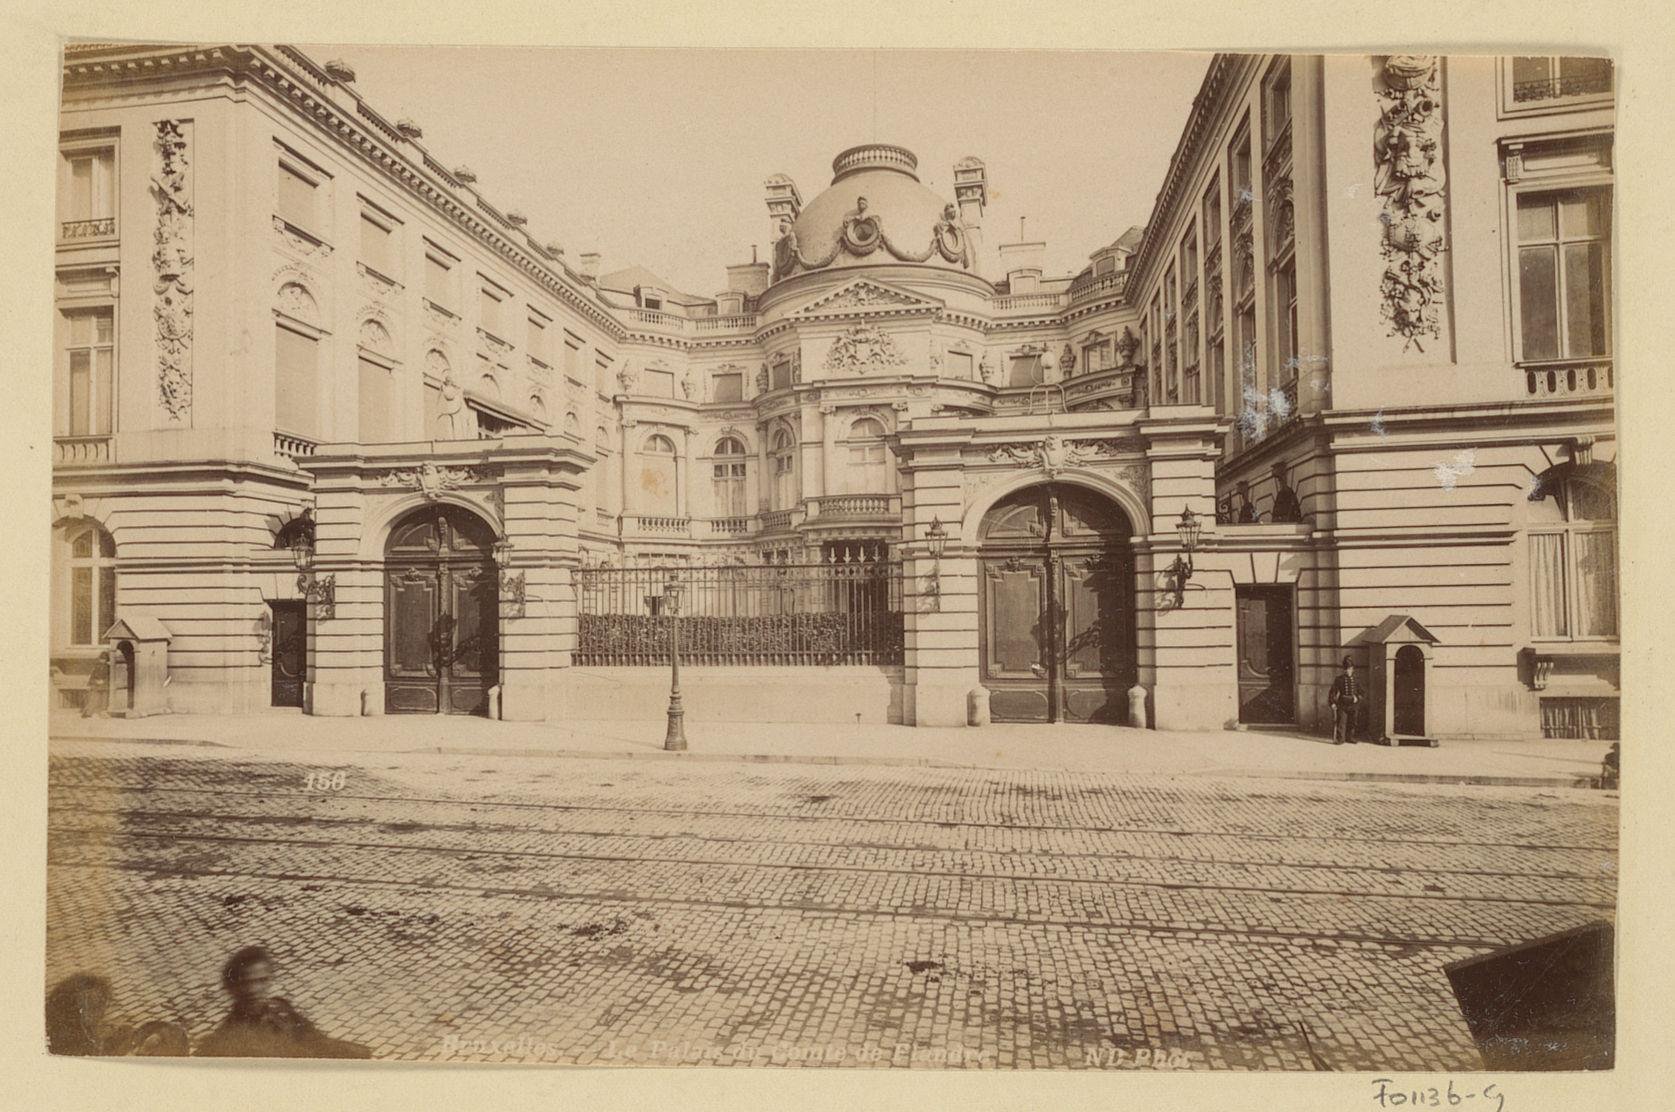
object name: photograph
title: Exterieur van het Paleis van de graaf van Vlaanderen in Brussel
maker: étienne neurdein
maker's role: publisher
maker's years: 1832-1918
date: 1870-1892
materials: photographic support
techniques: albumen print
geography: brussels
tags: palace, façade (of house or building), brussels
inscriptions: number: ‘15[...]’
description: Onderdeel van Fotoalbum met opnames van bezienswaardigheden in België, Duitsland en Noorwegen.